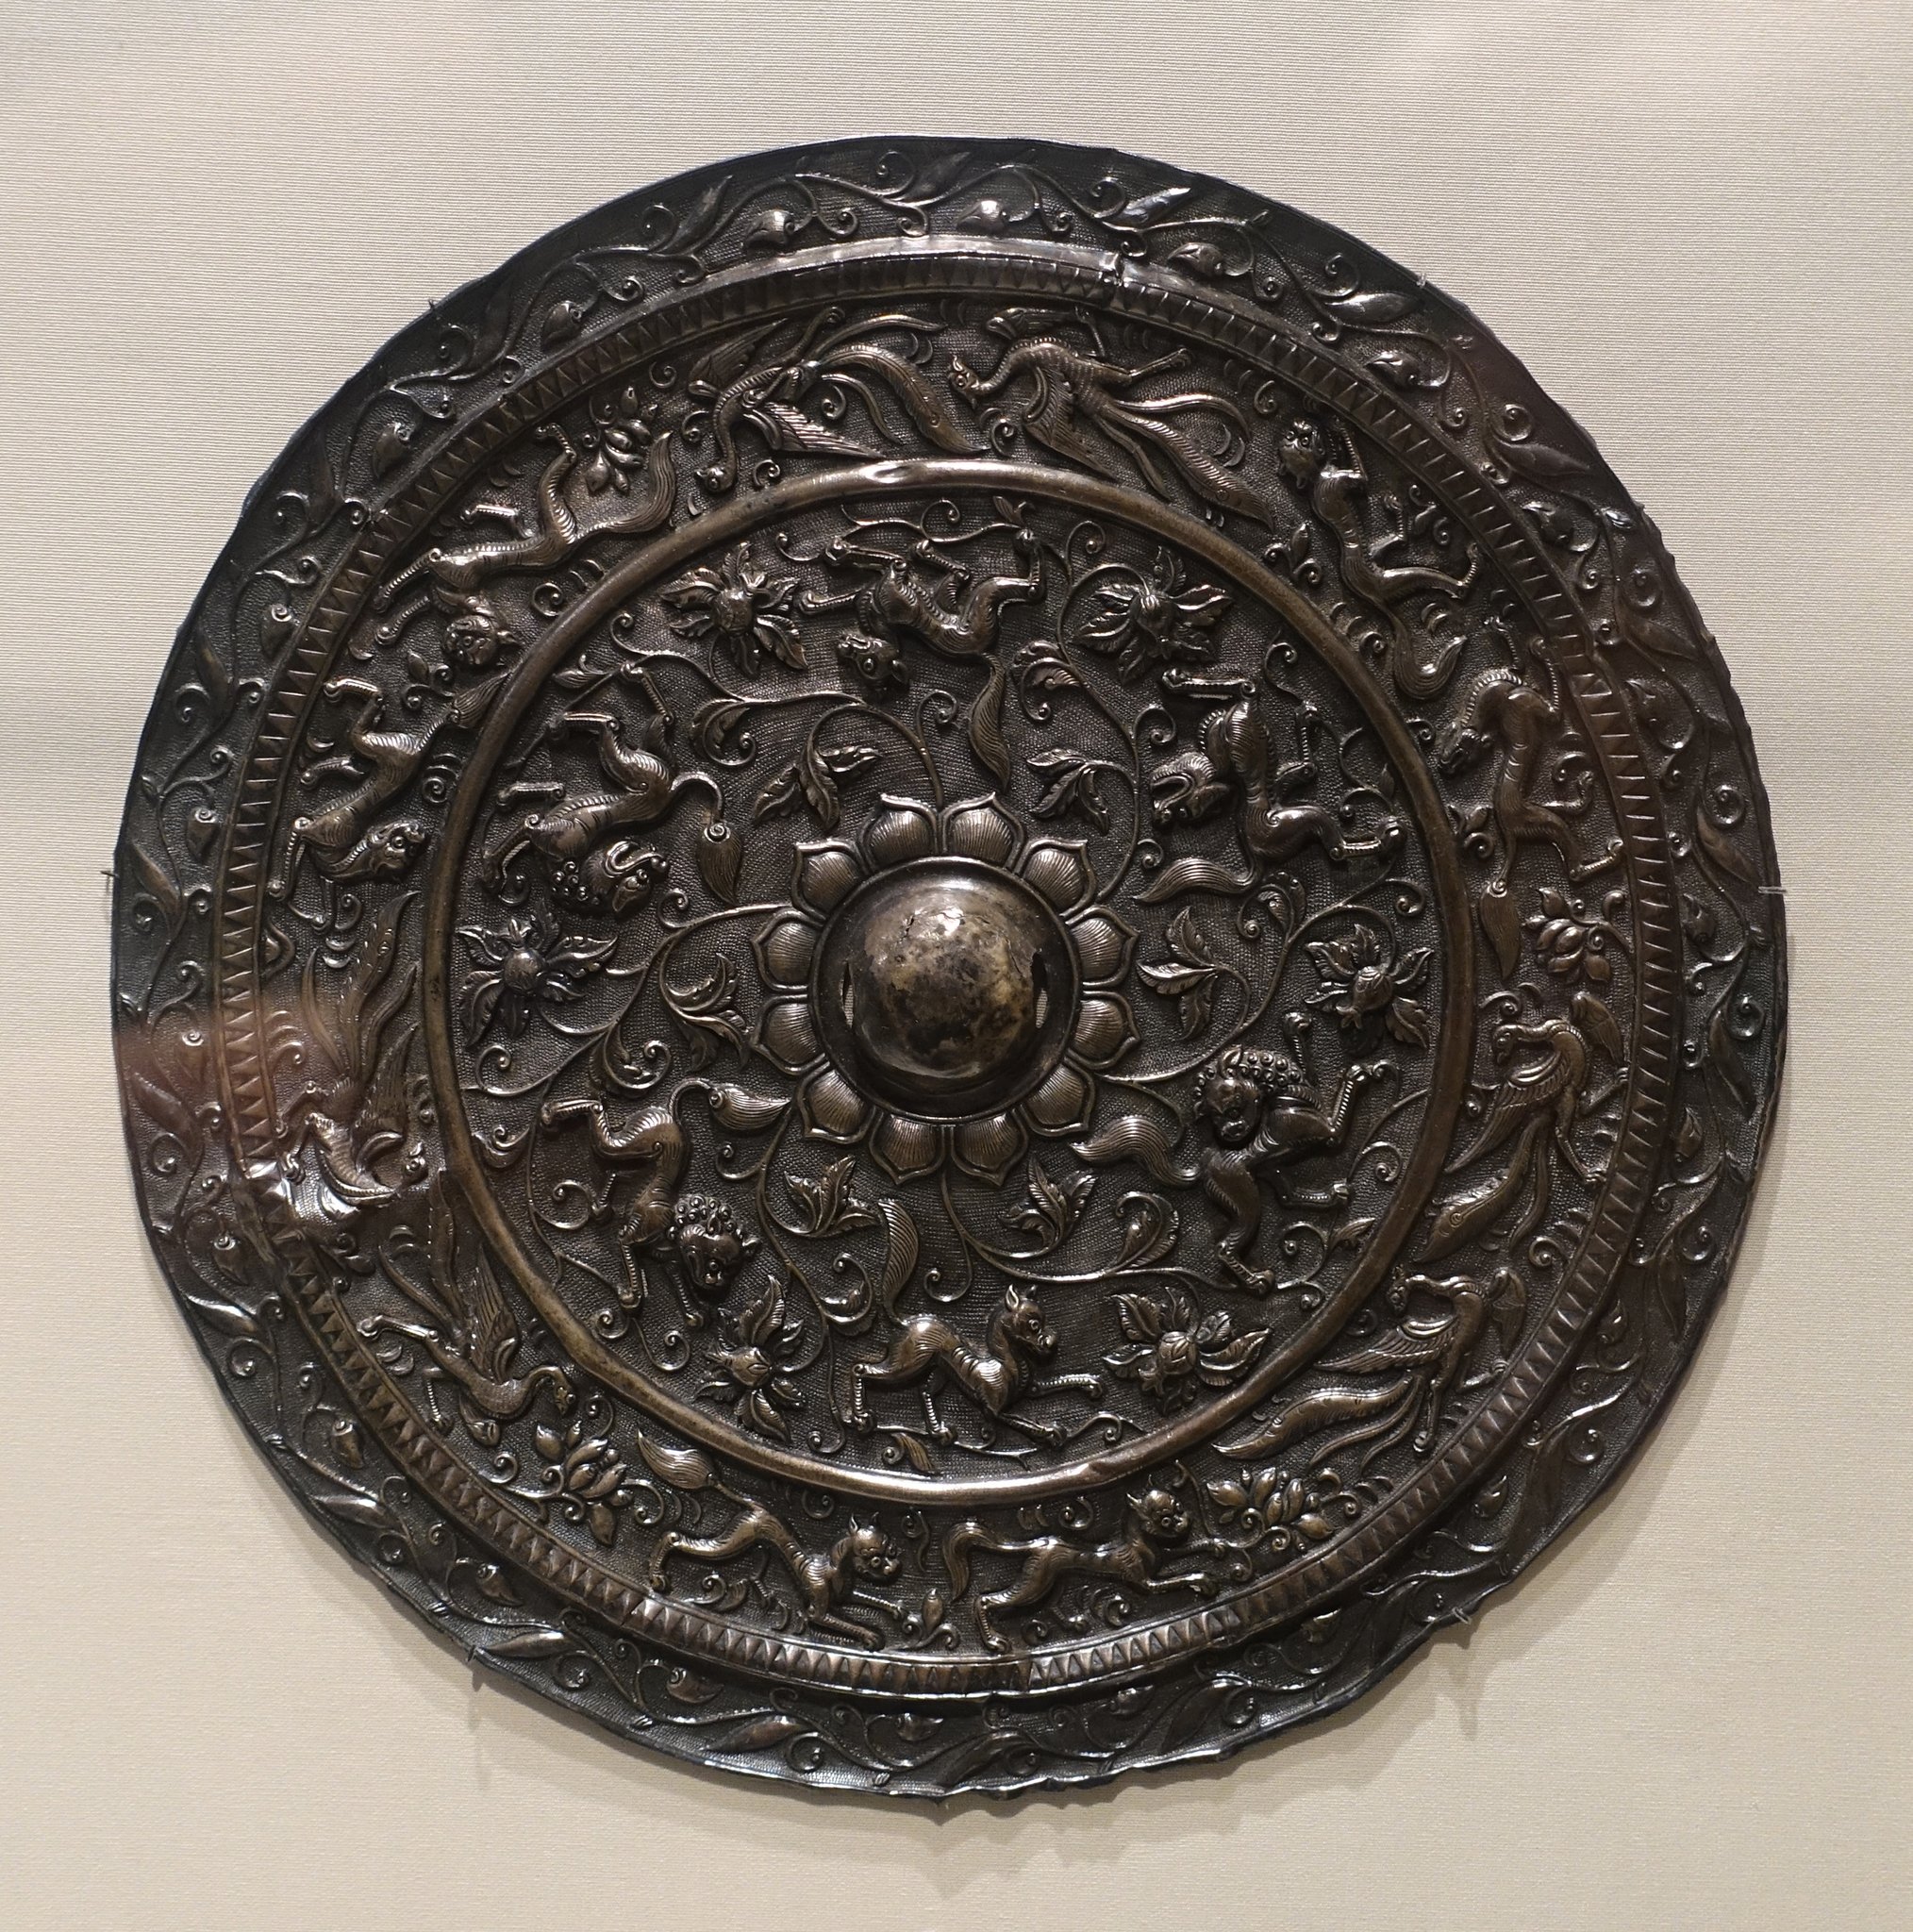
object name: mirror back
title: Mirror Back with Birds and Animals in Repoussé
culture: chinese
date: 701-800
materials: silver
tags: animals,birds